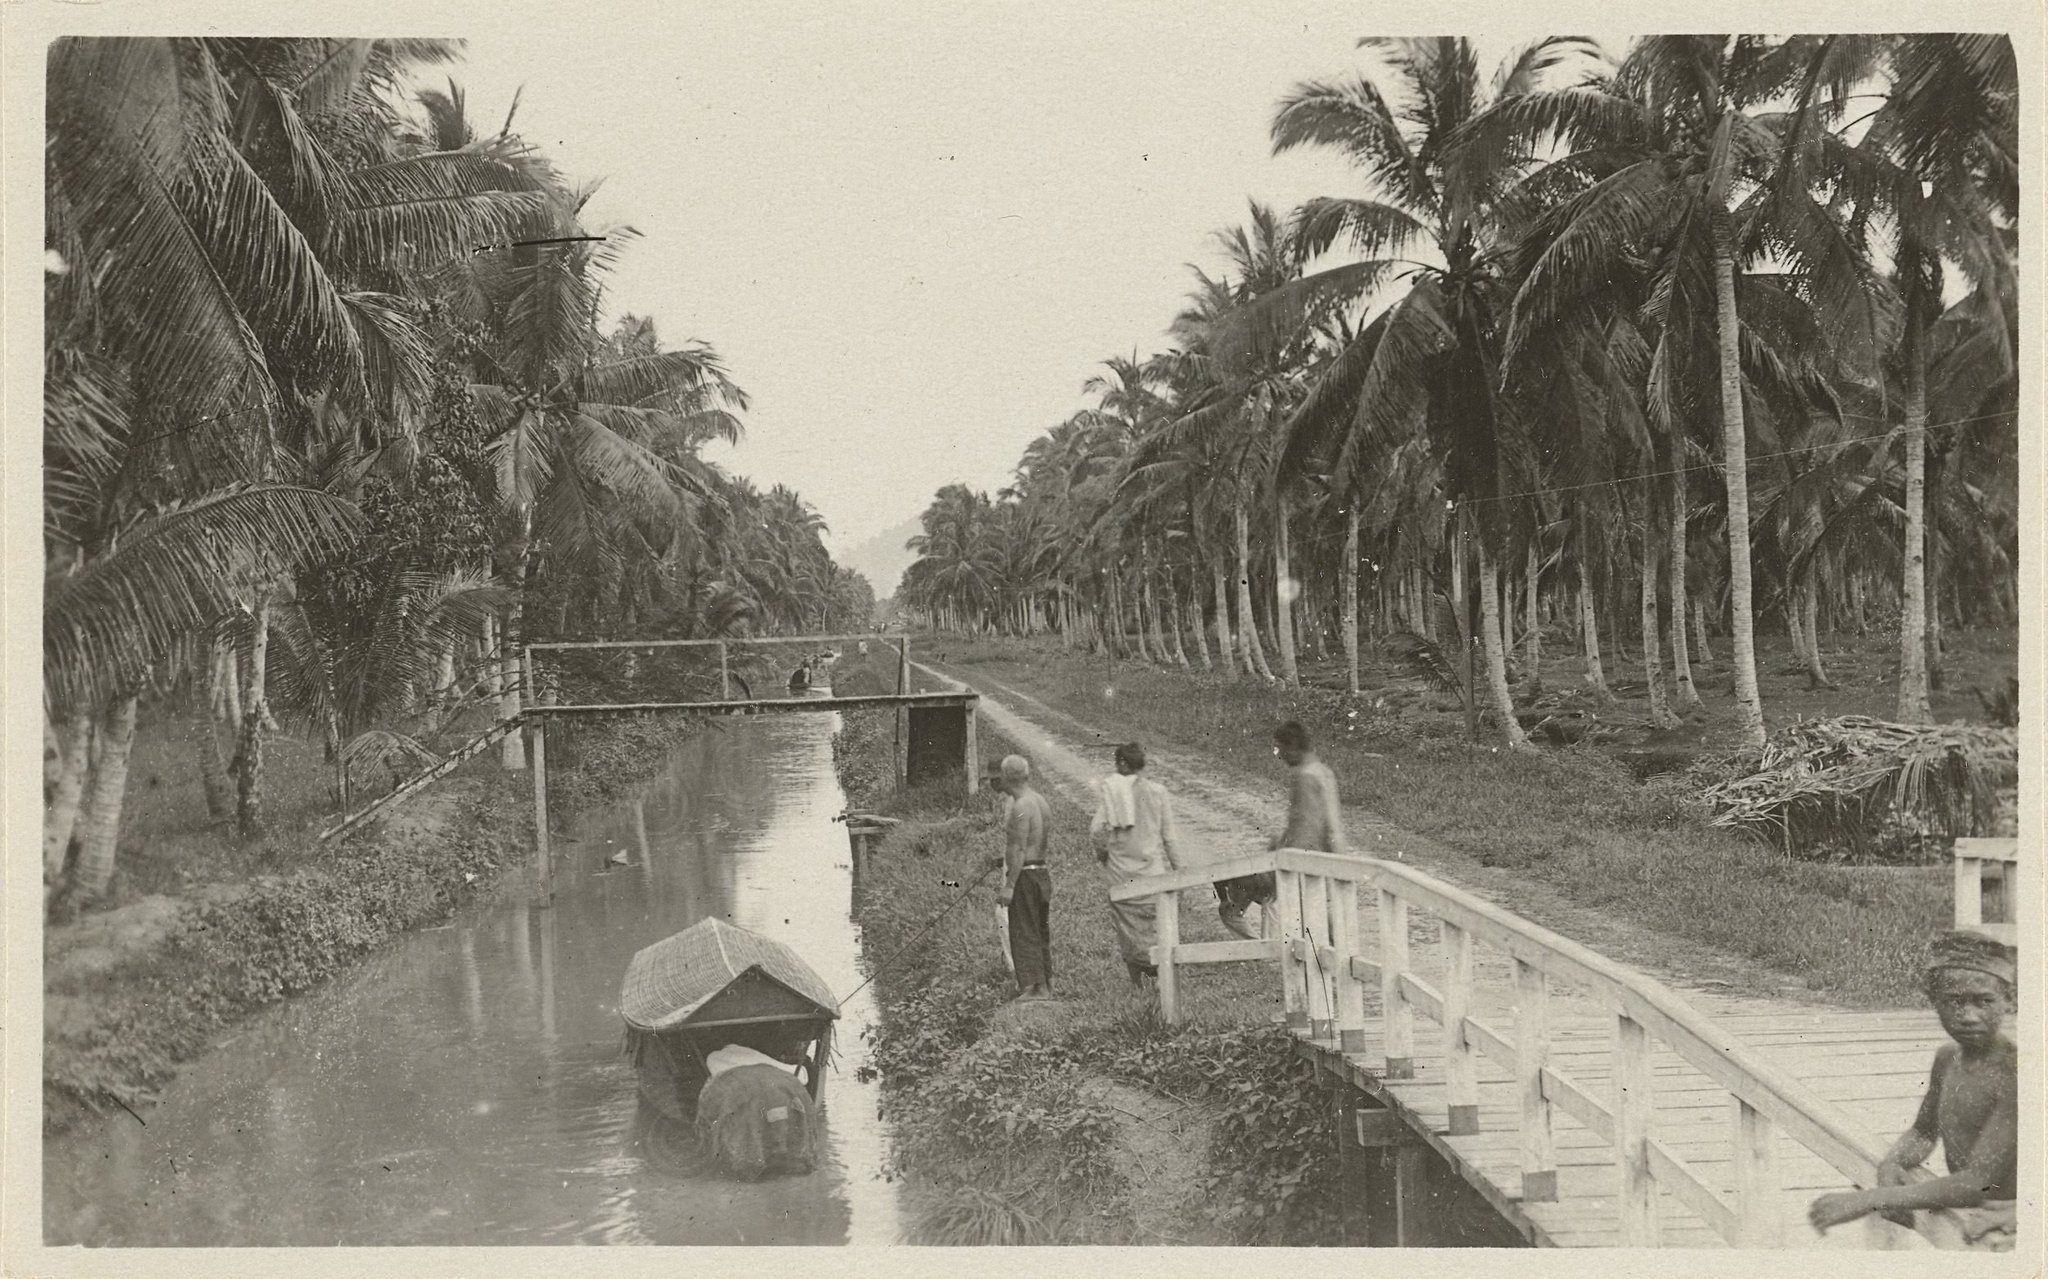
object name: photograph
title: Water langs een palmplantage in Indonesië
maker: Anonymous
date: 1920-1940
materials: photographic support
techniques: gelatin silver print